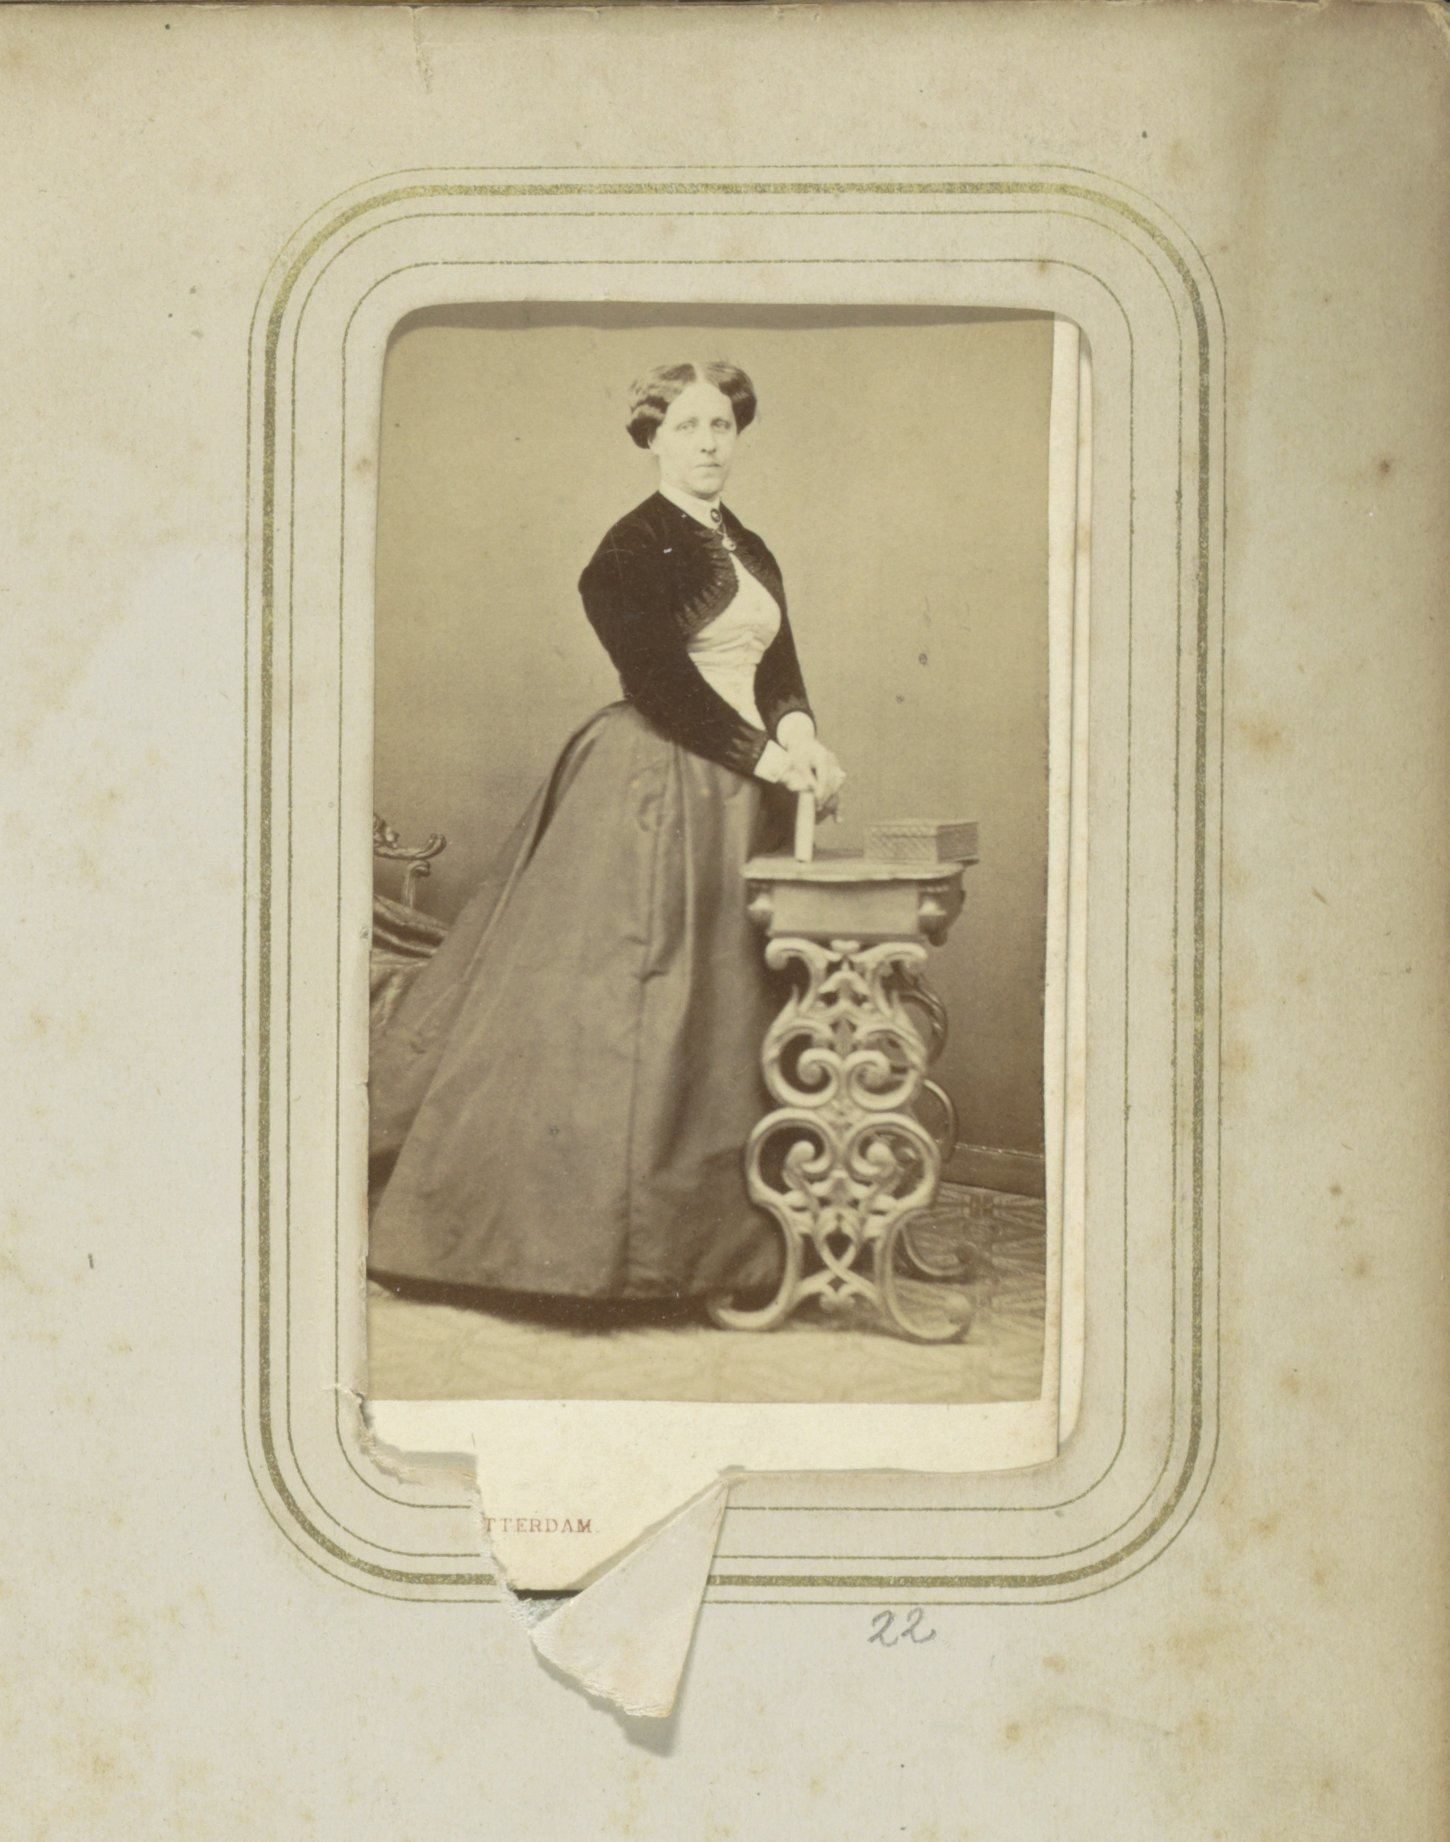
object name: carte de visite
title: Portret van een vrouw met een lange rok en een bolero bij een tafeltje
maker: johannes baer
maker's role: fotograaf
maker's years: 1840-1912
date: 1860-1880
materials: cardboard, photographic support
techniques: albumen print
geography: rotterdam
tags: studio requisites ~ photographer, clothing for the lower part of the body, historical persons, styles of hairdress - aa - ~ women, clothing for the upper part of the body, skirt, family, relationship, descent, the hague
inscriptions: address: ‘Rotterdam’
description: Onderdeel van Familiealbum van H.W.F. Ligtenberg en L.M. Swart met 149 foto's en cartes-de-visite.